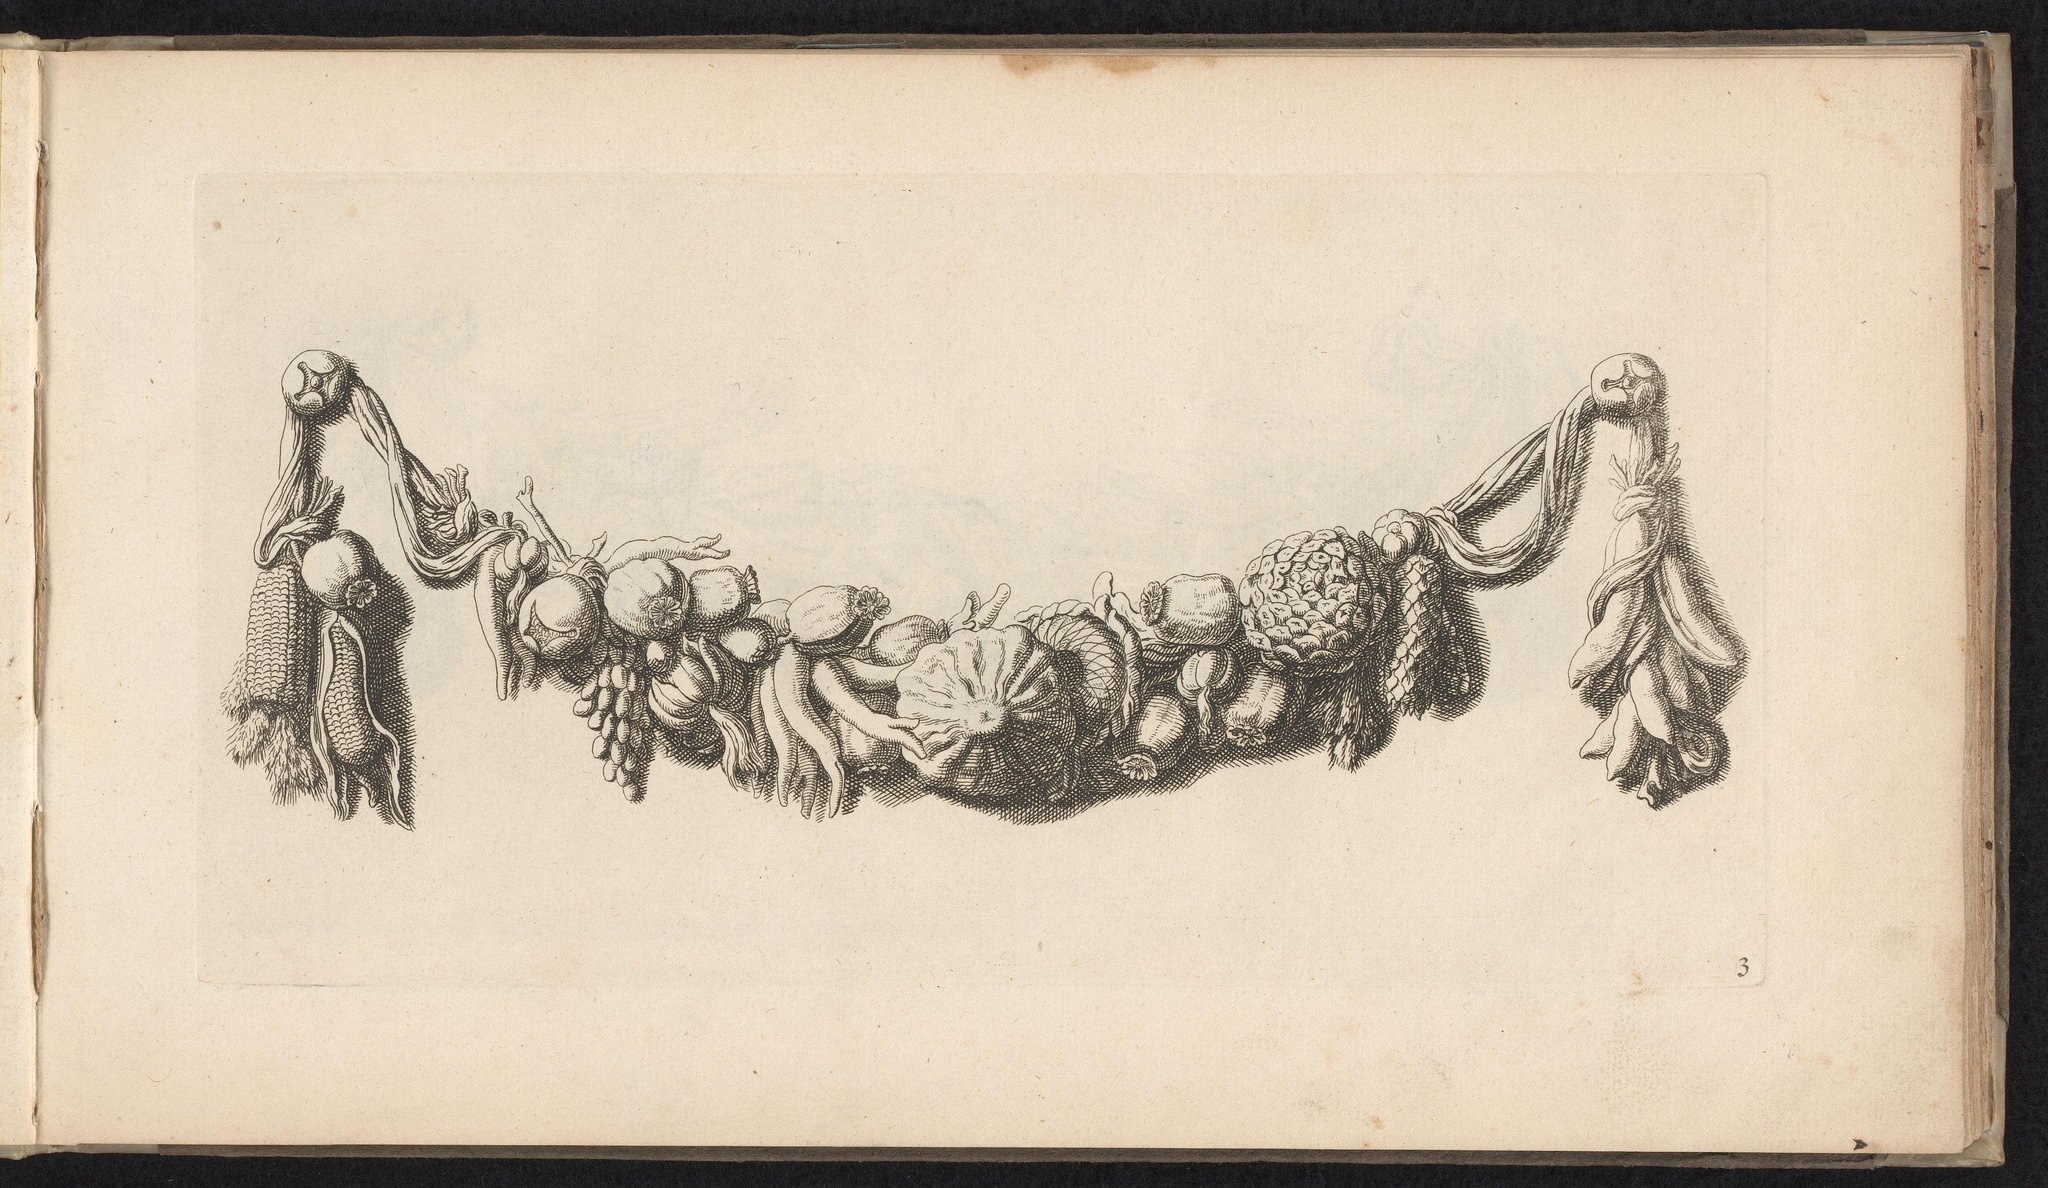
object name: ornament print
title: Festoen met dennenappels, maïs en papavers uit het stadhuis van Amsterdam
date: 1665-1685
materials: ink, paper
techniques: etching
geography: amsterdam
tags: fruits: pine-cone, ornament ~ festoon, garland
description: Prent uit elf genummerde prenten met festoenen. Kopieën in dezelfde richting naar de prenten in Artus Quellinus, Prima Pars Praecipuarium (…), Amsterdam 1665. Gebonden in 19de-eeuwse band met blauwe kaft en witte rug, genummerd: 3.